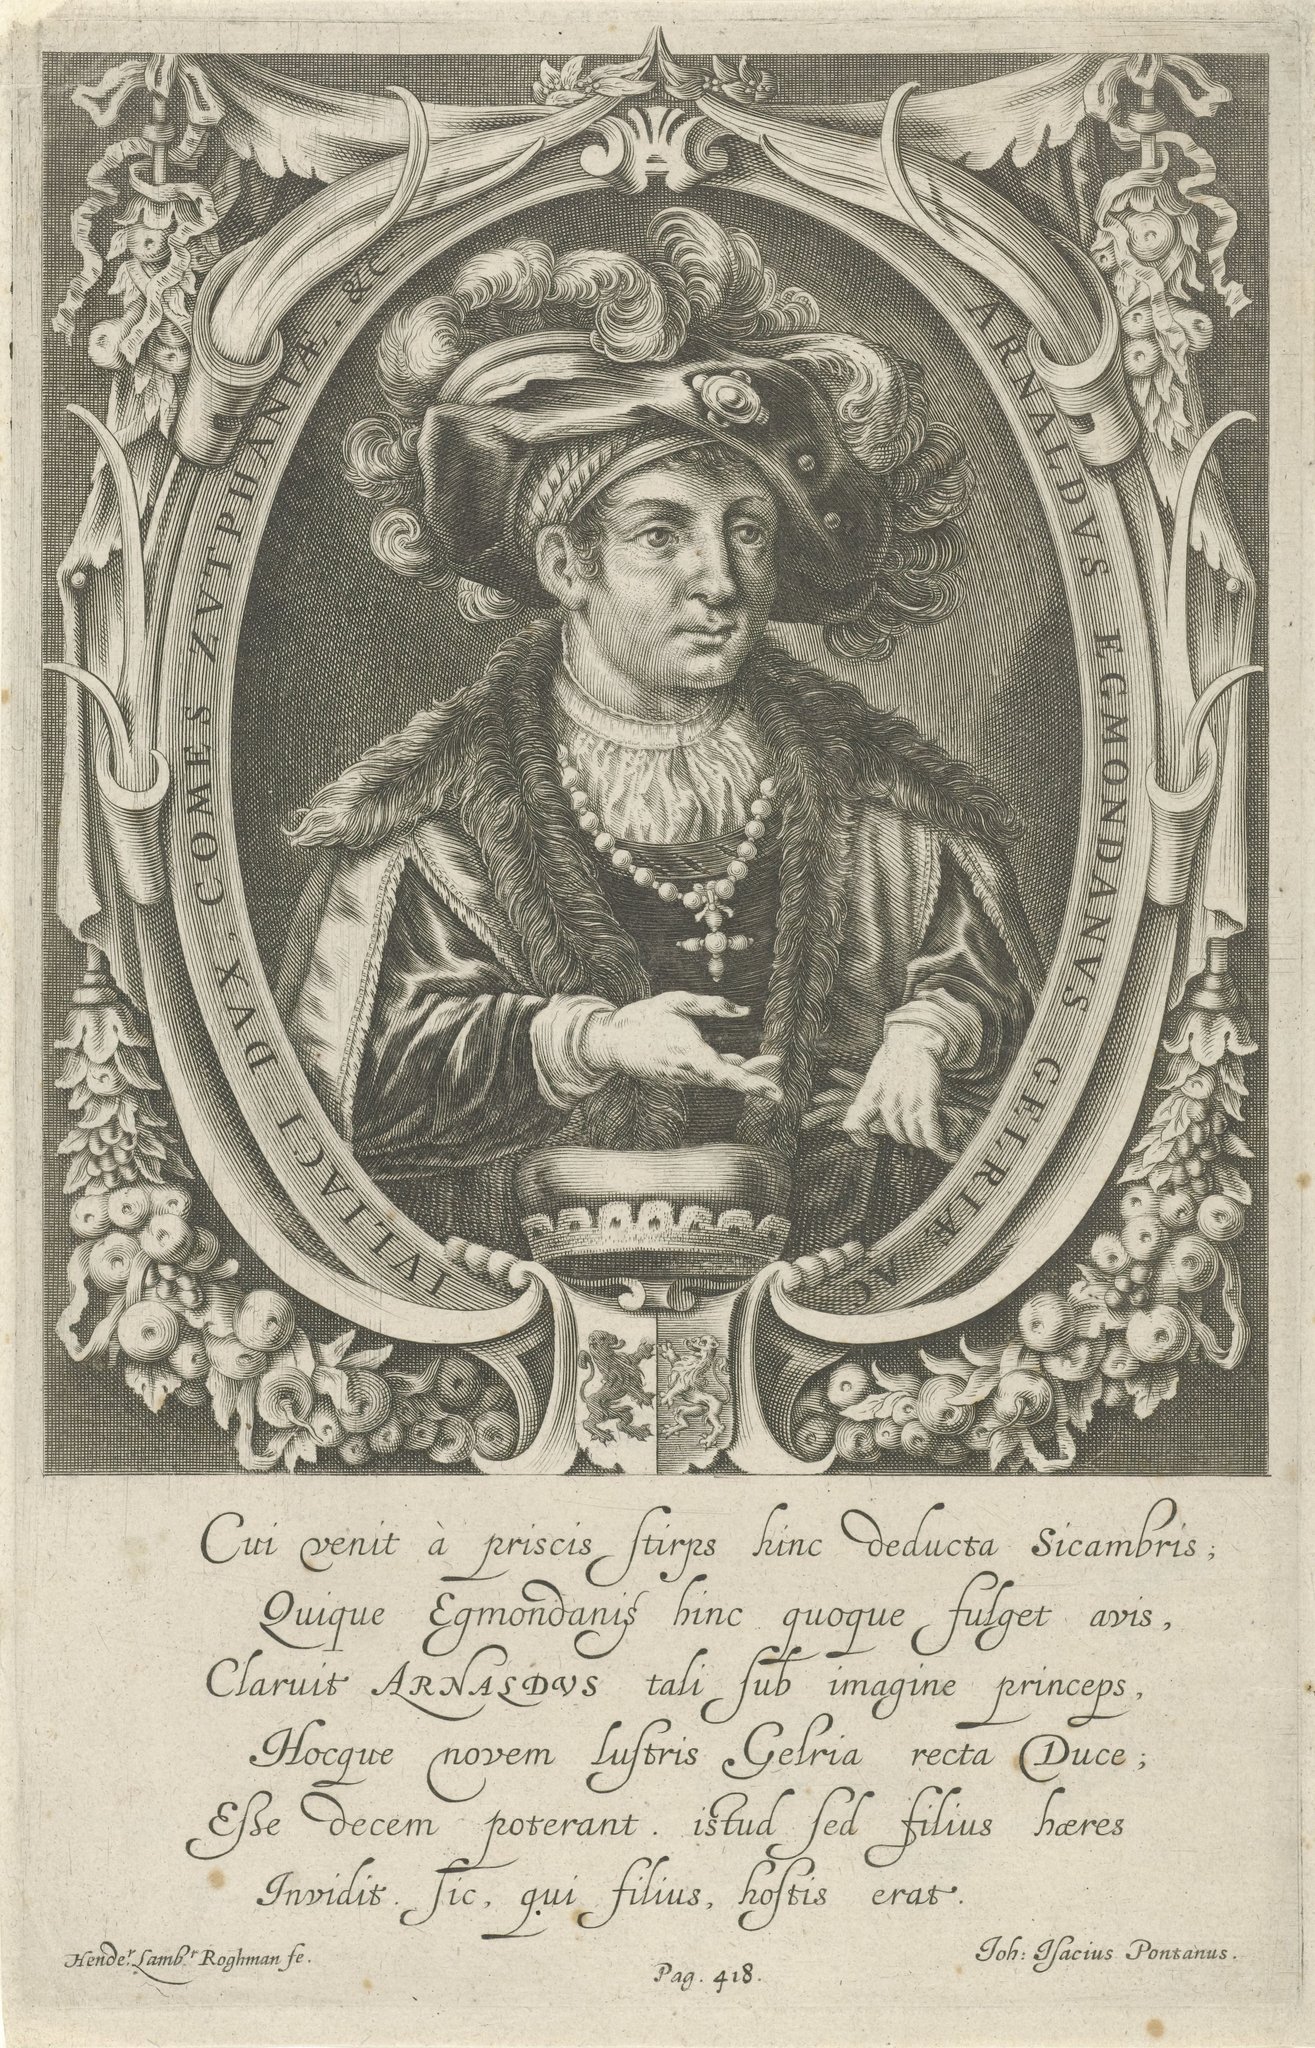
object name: print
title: Portret van Aarnout van Egmond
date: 1639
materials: paper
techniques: engraving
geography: northern netherlands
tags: grave, earl, head-gear, fruits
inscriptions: collector's mark: Lugt 2228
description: Portret van Aarnout van Egmond, hertog van Gelre en graaf van Zutphen. Het portret is gevat in een met vruchten gedecoreerde cartouche, met onderaan het wapen van Gelderland. In de marge een vers in het Latijn.